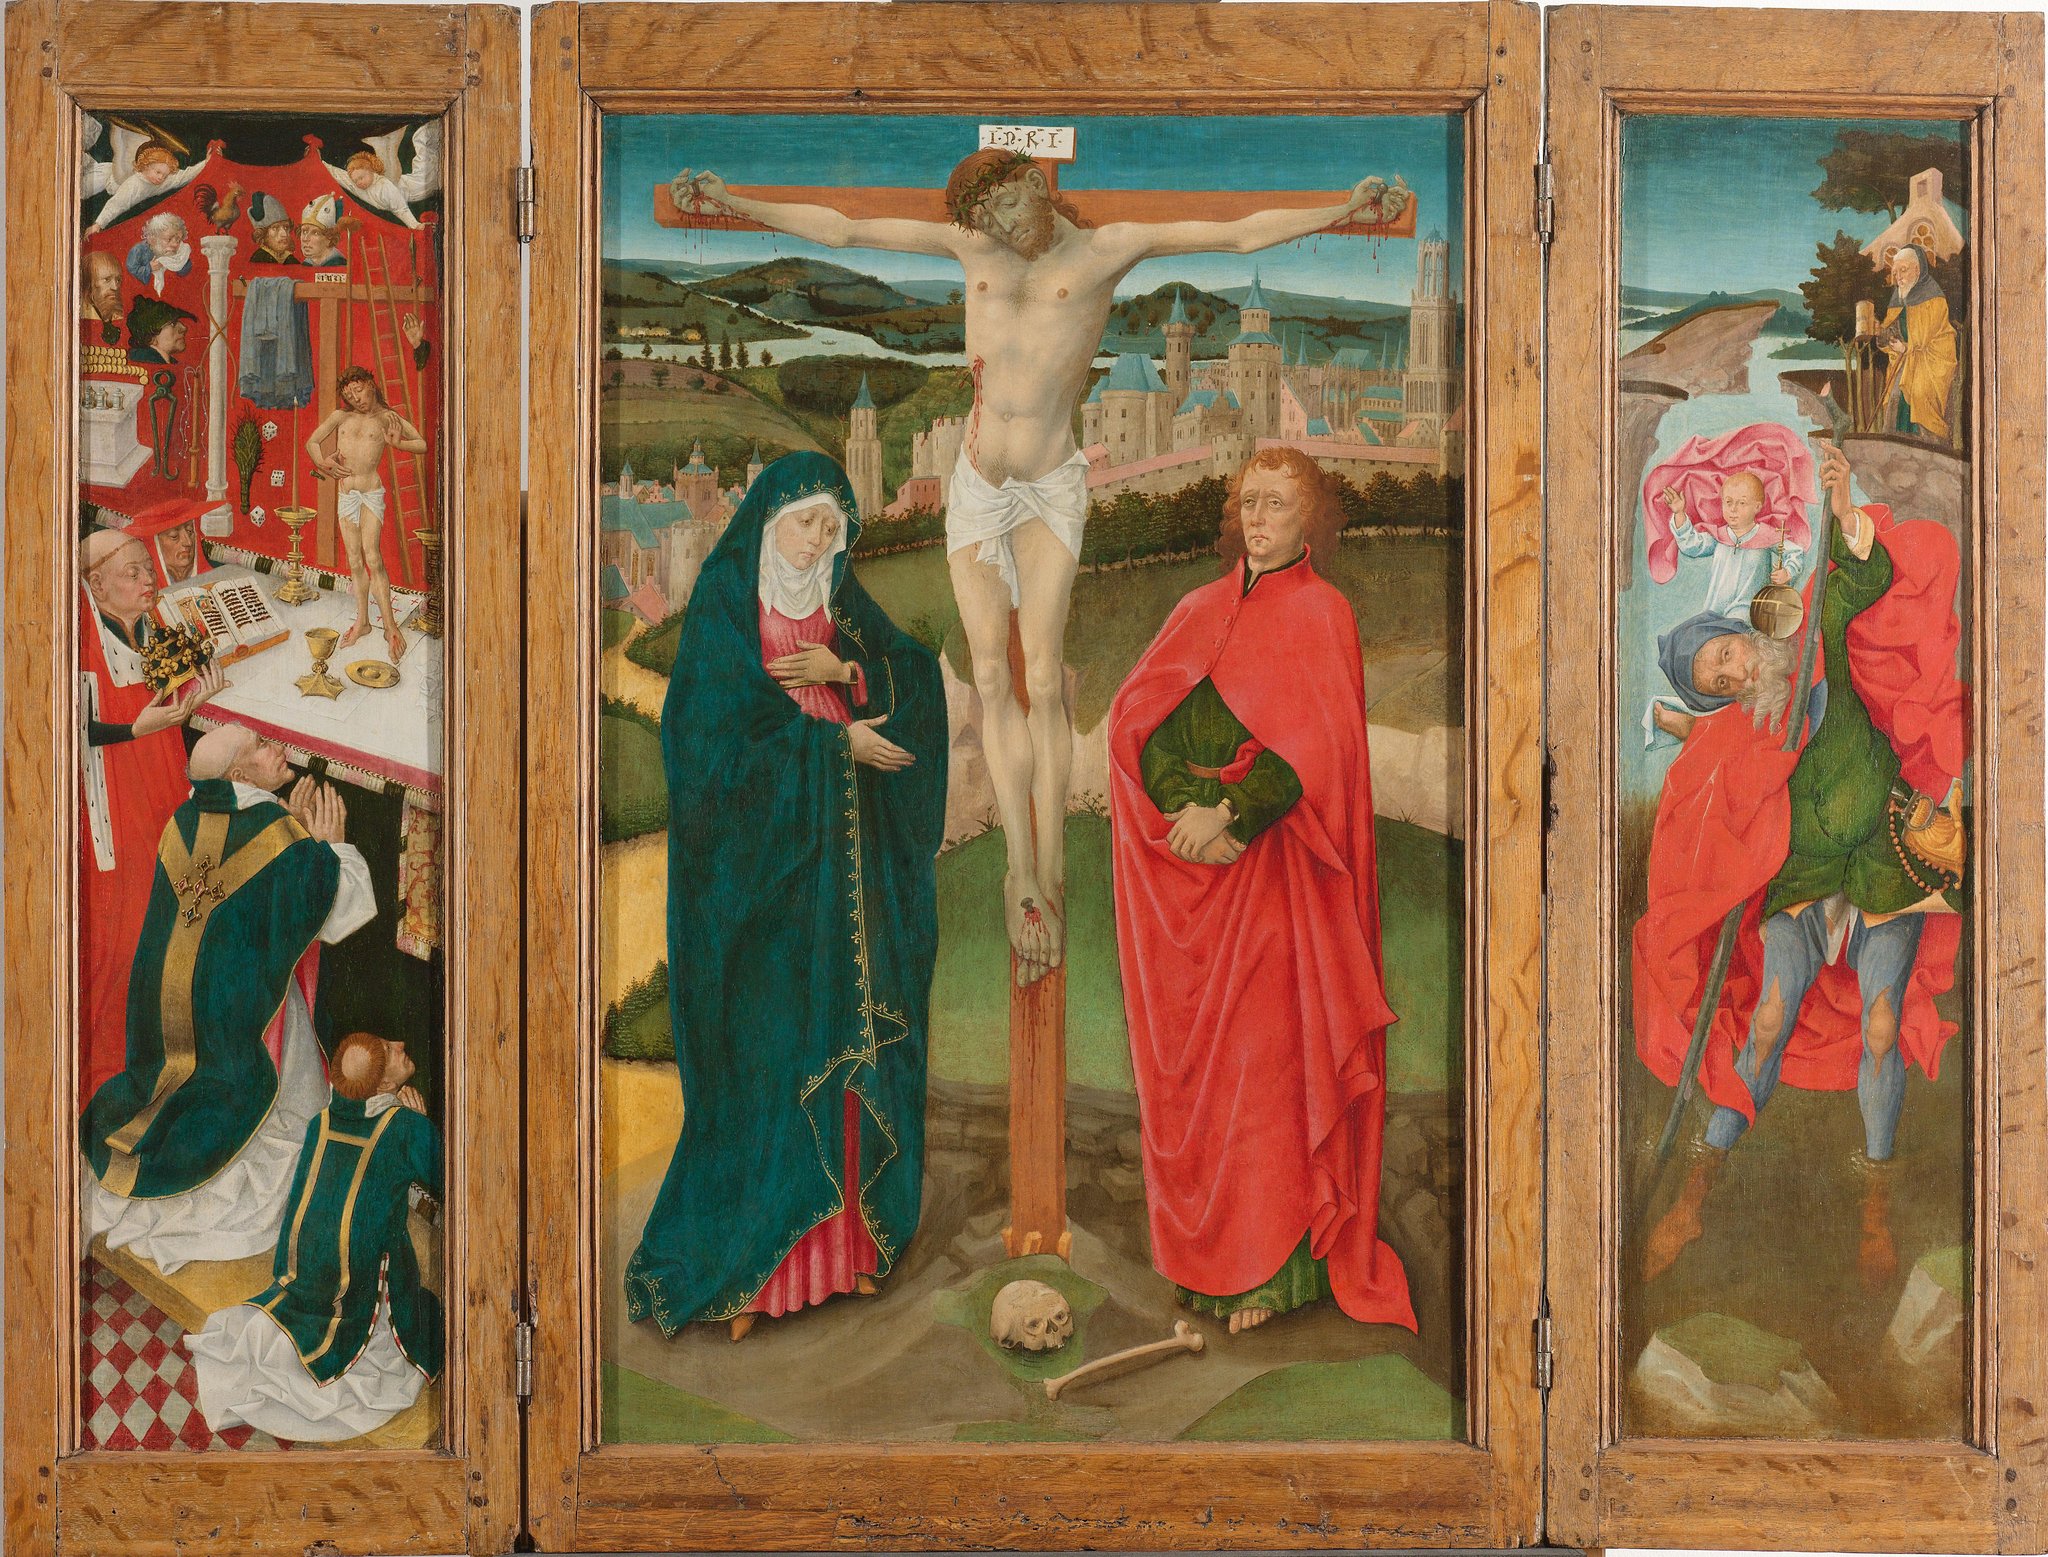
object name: triptych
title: Triptych with the Crucifixion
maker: Anonymous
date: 1460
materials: oil, panel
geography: utrecht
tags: the annunciation: mary, usually reading, is visited by the angel (sometimes a woman overhears the conversation), st. christopher, with the infant christ on his shoulders, wading through the water and carrying his staff (palm-tree); sometimes a hermit stands on the further bank beside a chapel, a lantern in his hand, the mass of st. gregory the great: christ appears above the altar with the instruments of the passion; maybe blood spouts from christ's side, crucified christ with mary and john on either side of the cross; holy rood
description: The Crucifixion at centre is set against the background of the city of Utrecht. Thus the biblical scene acquired a certain reality for the medieval viewer. At left is Pope Gregory the Great, who experienced a vision of Christ while celebrating Mass. At right is Saint Christopher who bears the Christ Child and the burden of mankind on his shoulders.